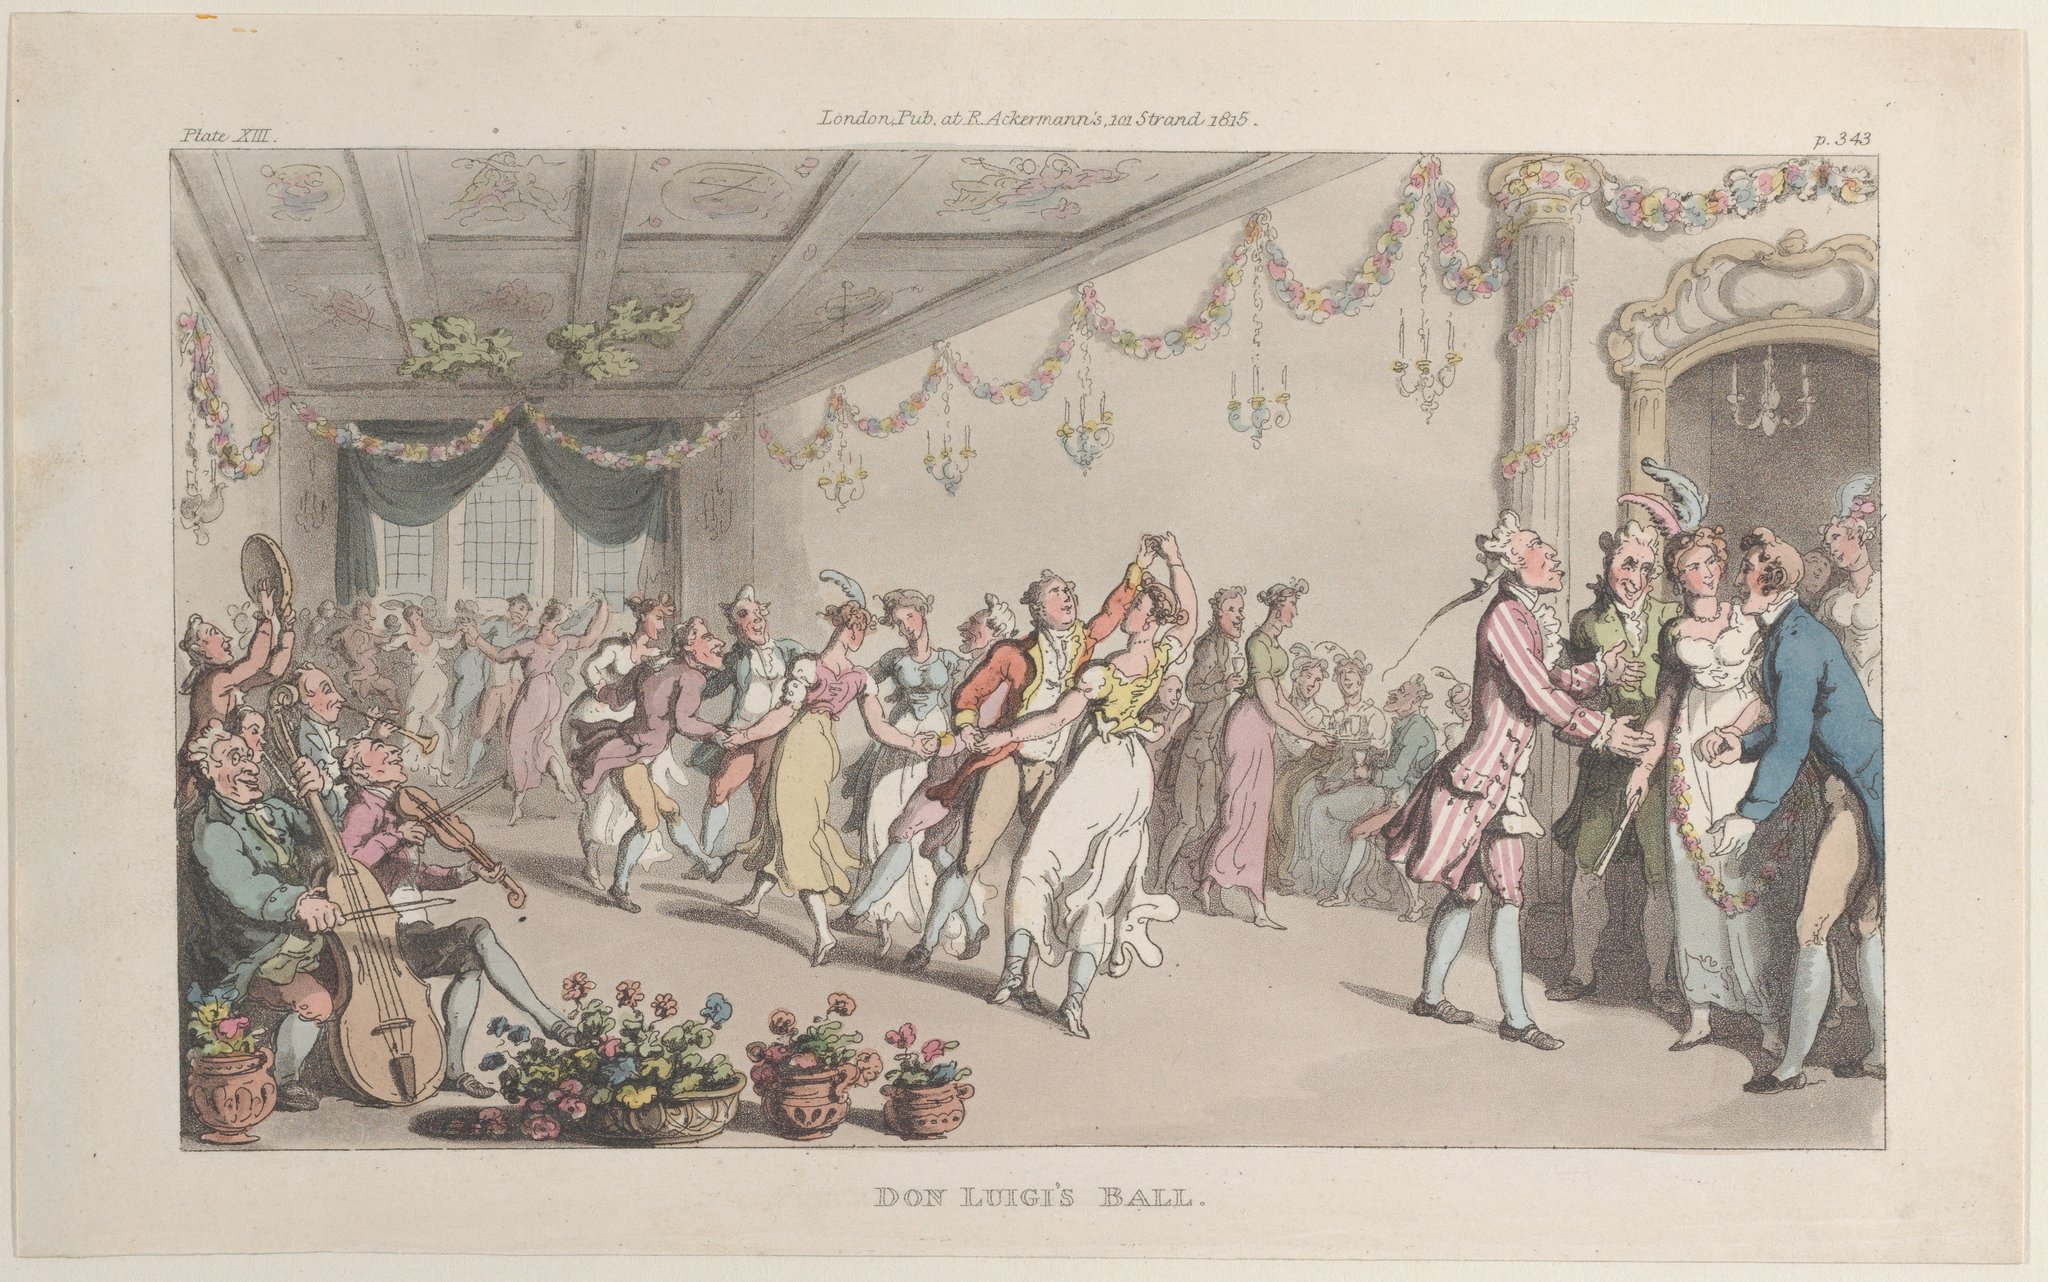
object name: print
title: Don Luigi's Ball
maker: thomas rowlandson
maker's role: artist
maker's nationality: british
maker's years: 1757-1827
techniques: aquatint, etching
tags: men,women,dancing,musicians